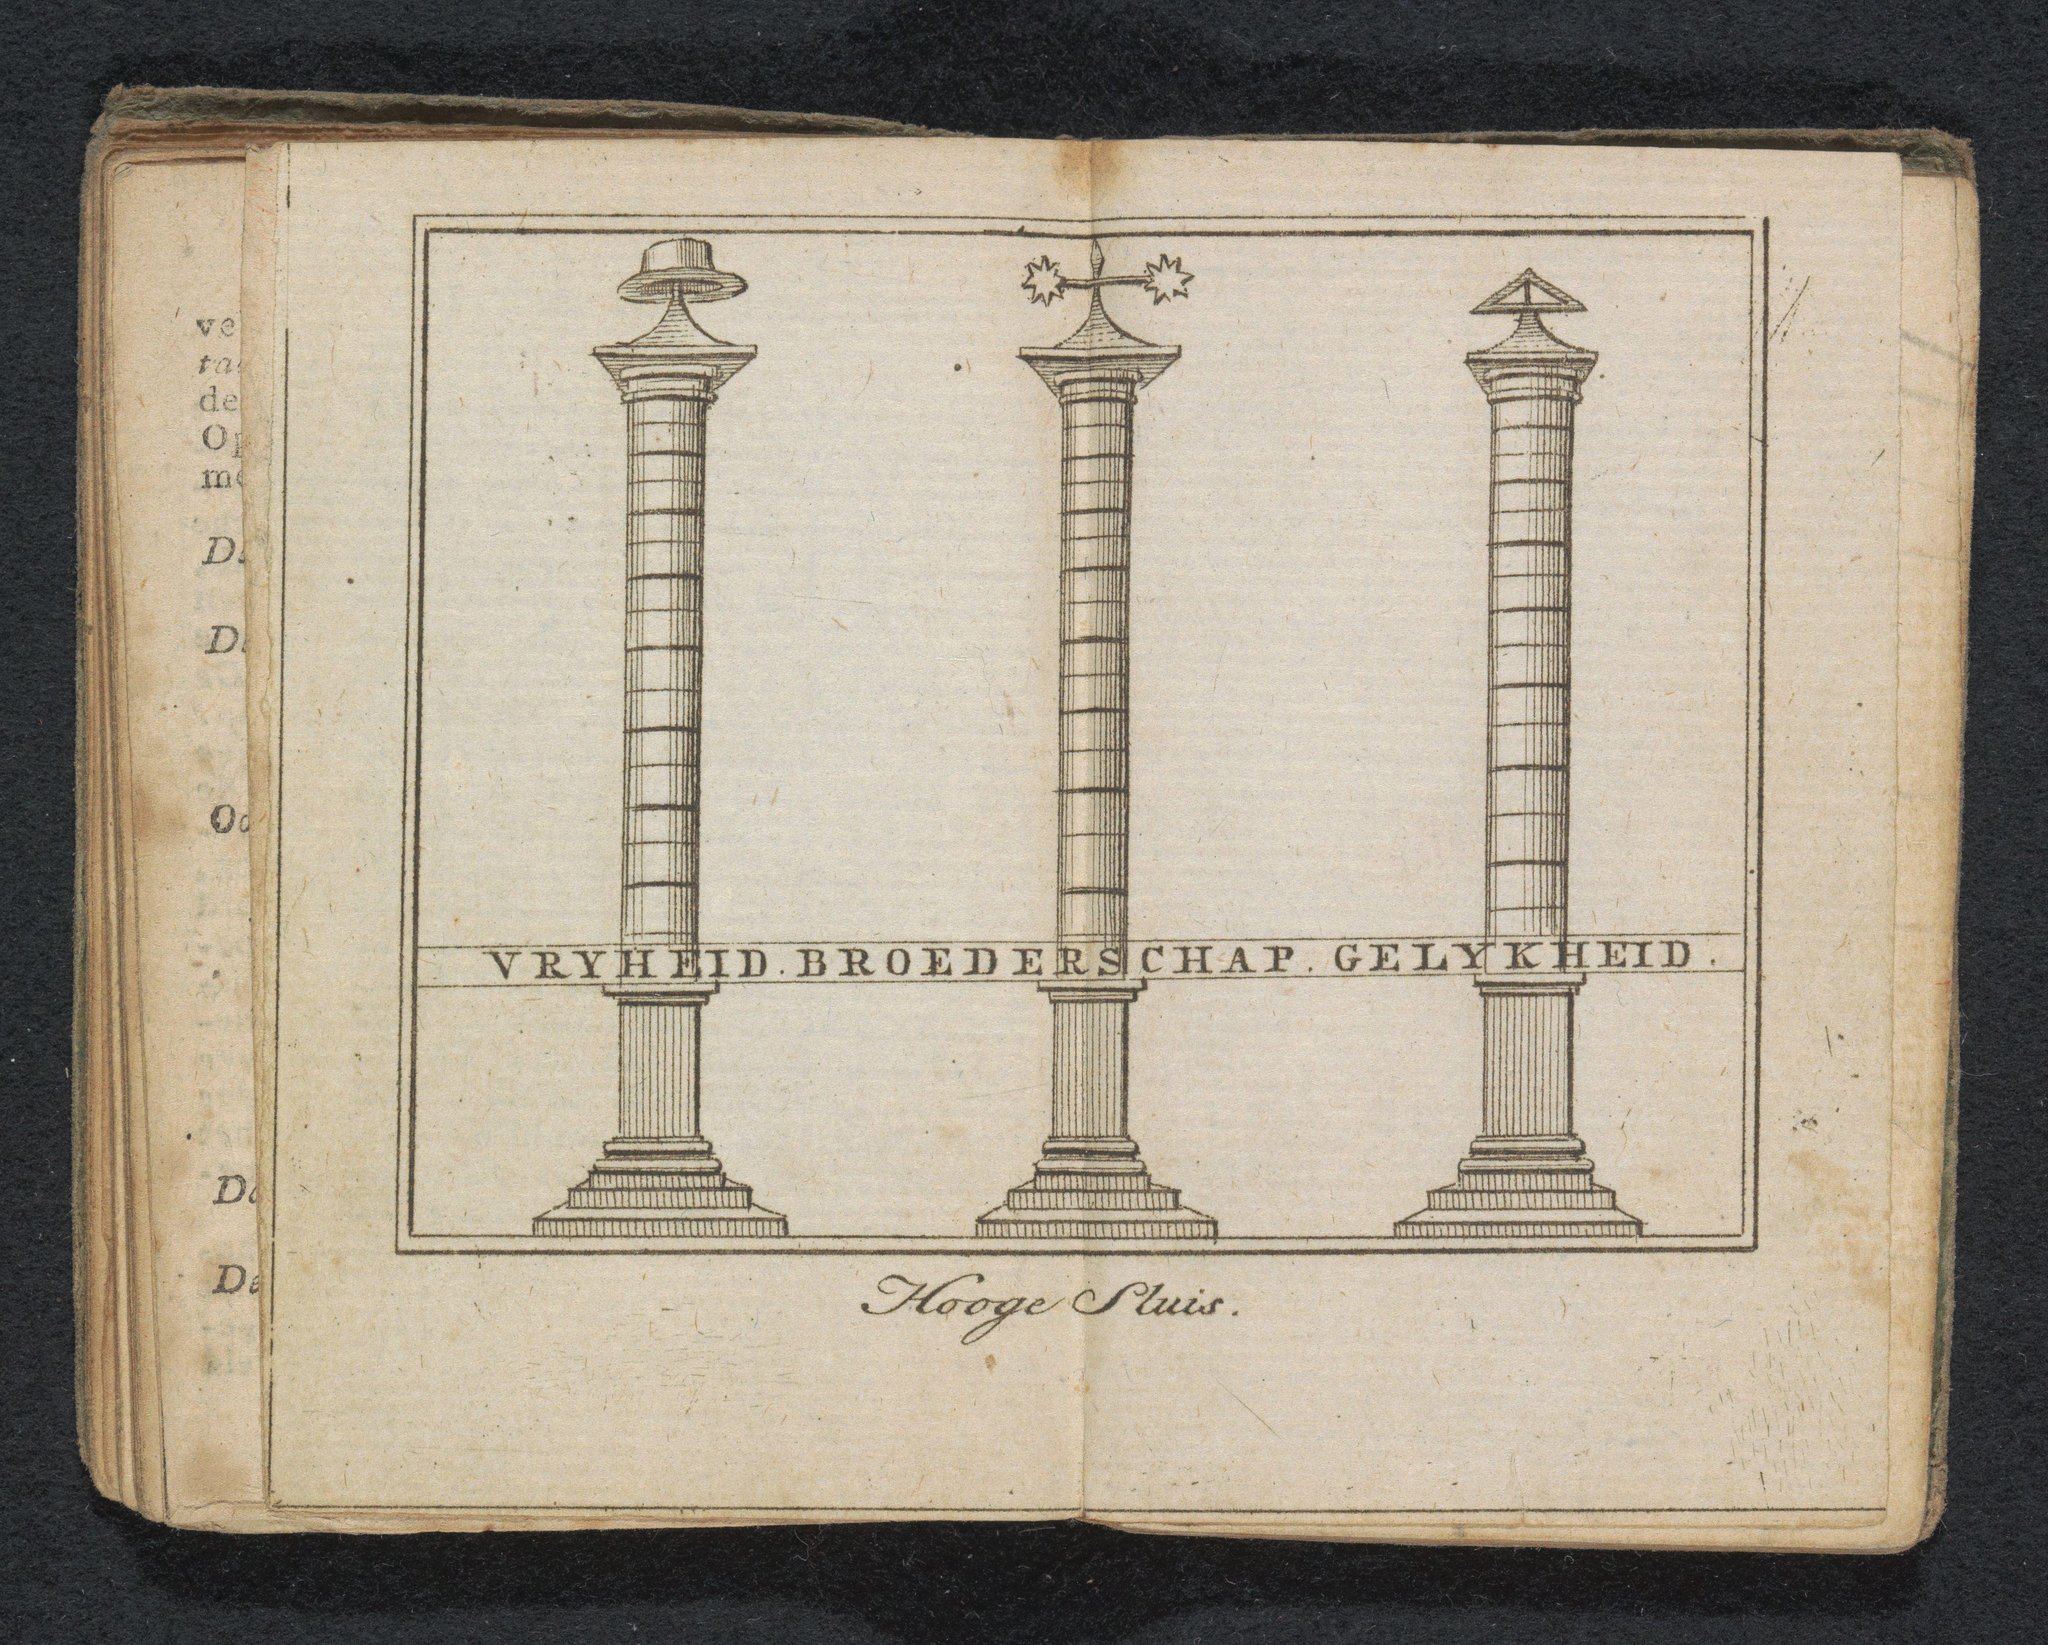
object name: book illustration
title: Vrijheid, Broederschap en Gelijkheid, decoratie op de Hogesluis, 1795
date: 1795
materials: paper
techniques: etching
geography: netherlands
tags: festivities on events of national importance (+ festive decoration ~ festive activities), alliance with france (1795)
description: Drie zuilen voor Vrijheid, Broederschap en Gelijkheid, allegorische decoratie opgericht op de Hogesluis aan de Amstel te Amsterdam bij het Alliantiefeest op 19 juni 1795. Drie zuilen bekroond met de symbolen van Vrijheid, Broederschap en Gelijkheid. Illustratie in het Bataafsche revolutie- en alliantie almanach voor 1796.